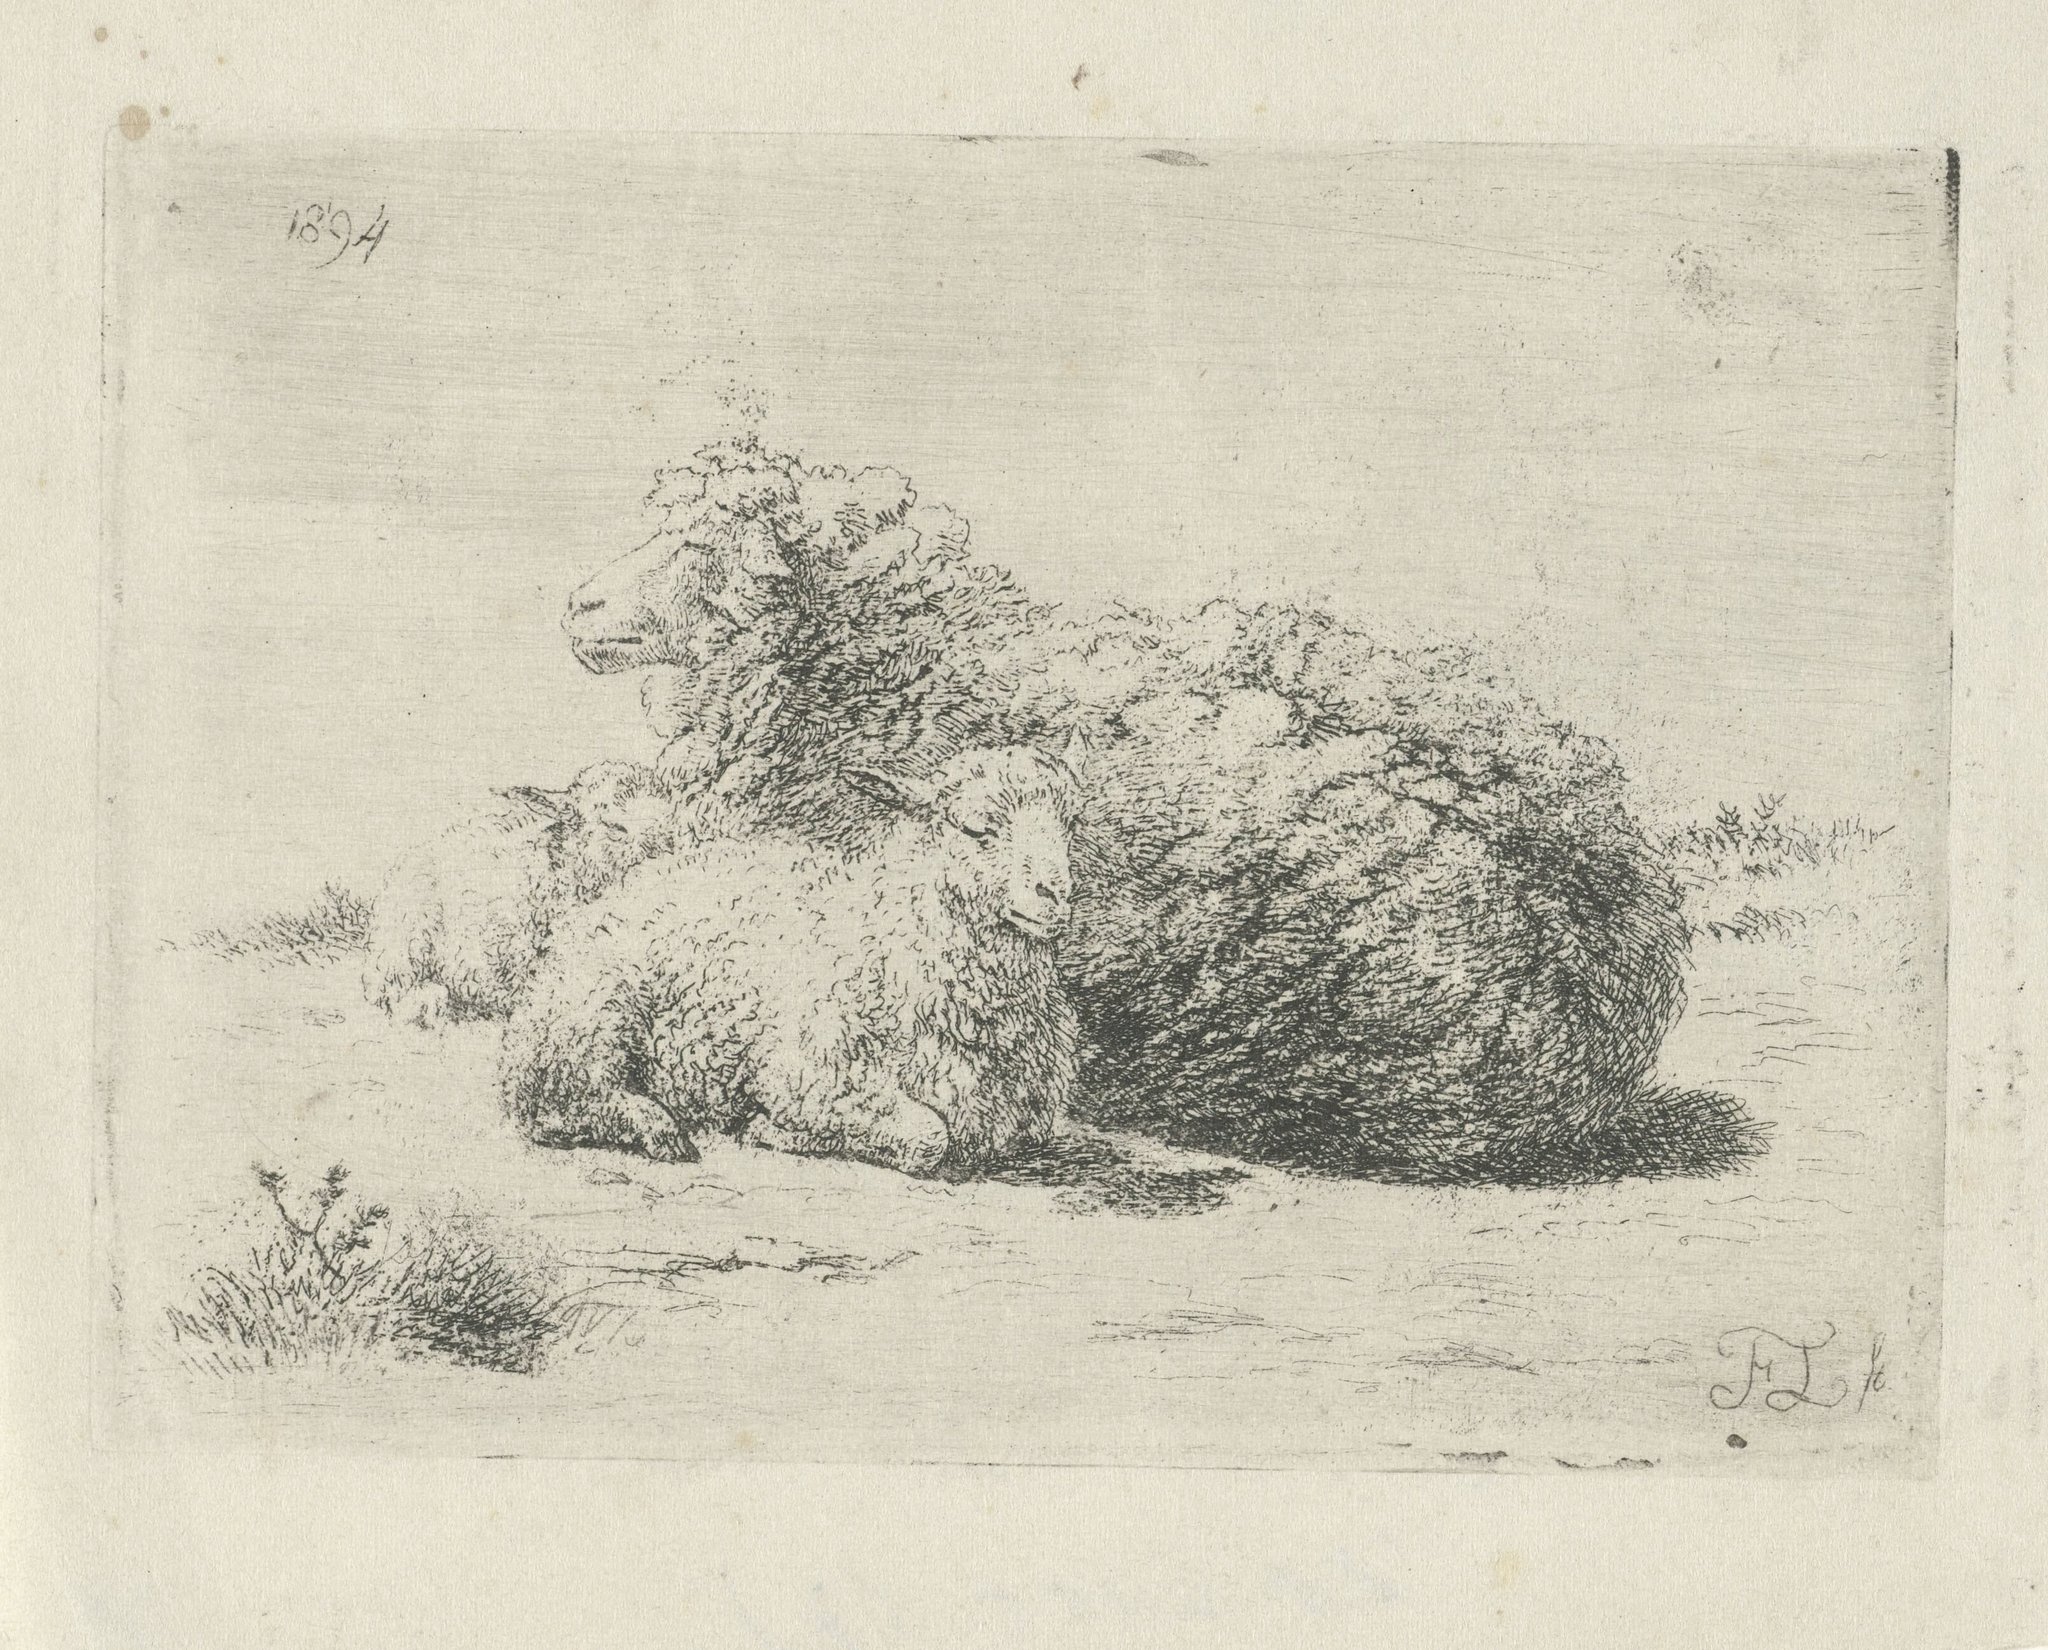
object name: print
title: Liggend schaap en twee lammeren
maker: frans lebret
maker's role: draughtsman, painter, print maker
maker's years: 1820-1909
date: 1894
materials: paper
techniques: etching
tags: lamb, sheep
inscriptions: collector's mark: Lugt 2228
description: Een liggend schaap in het gezelschap van twee liggende lammeren.